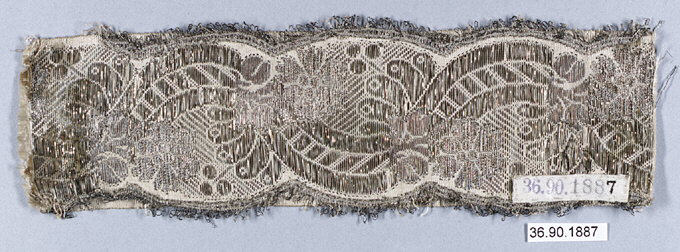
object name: galloon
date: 1767-1833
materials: metal thread, silk